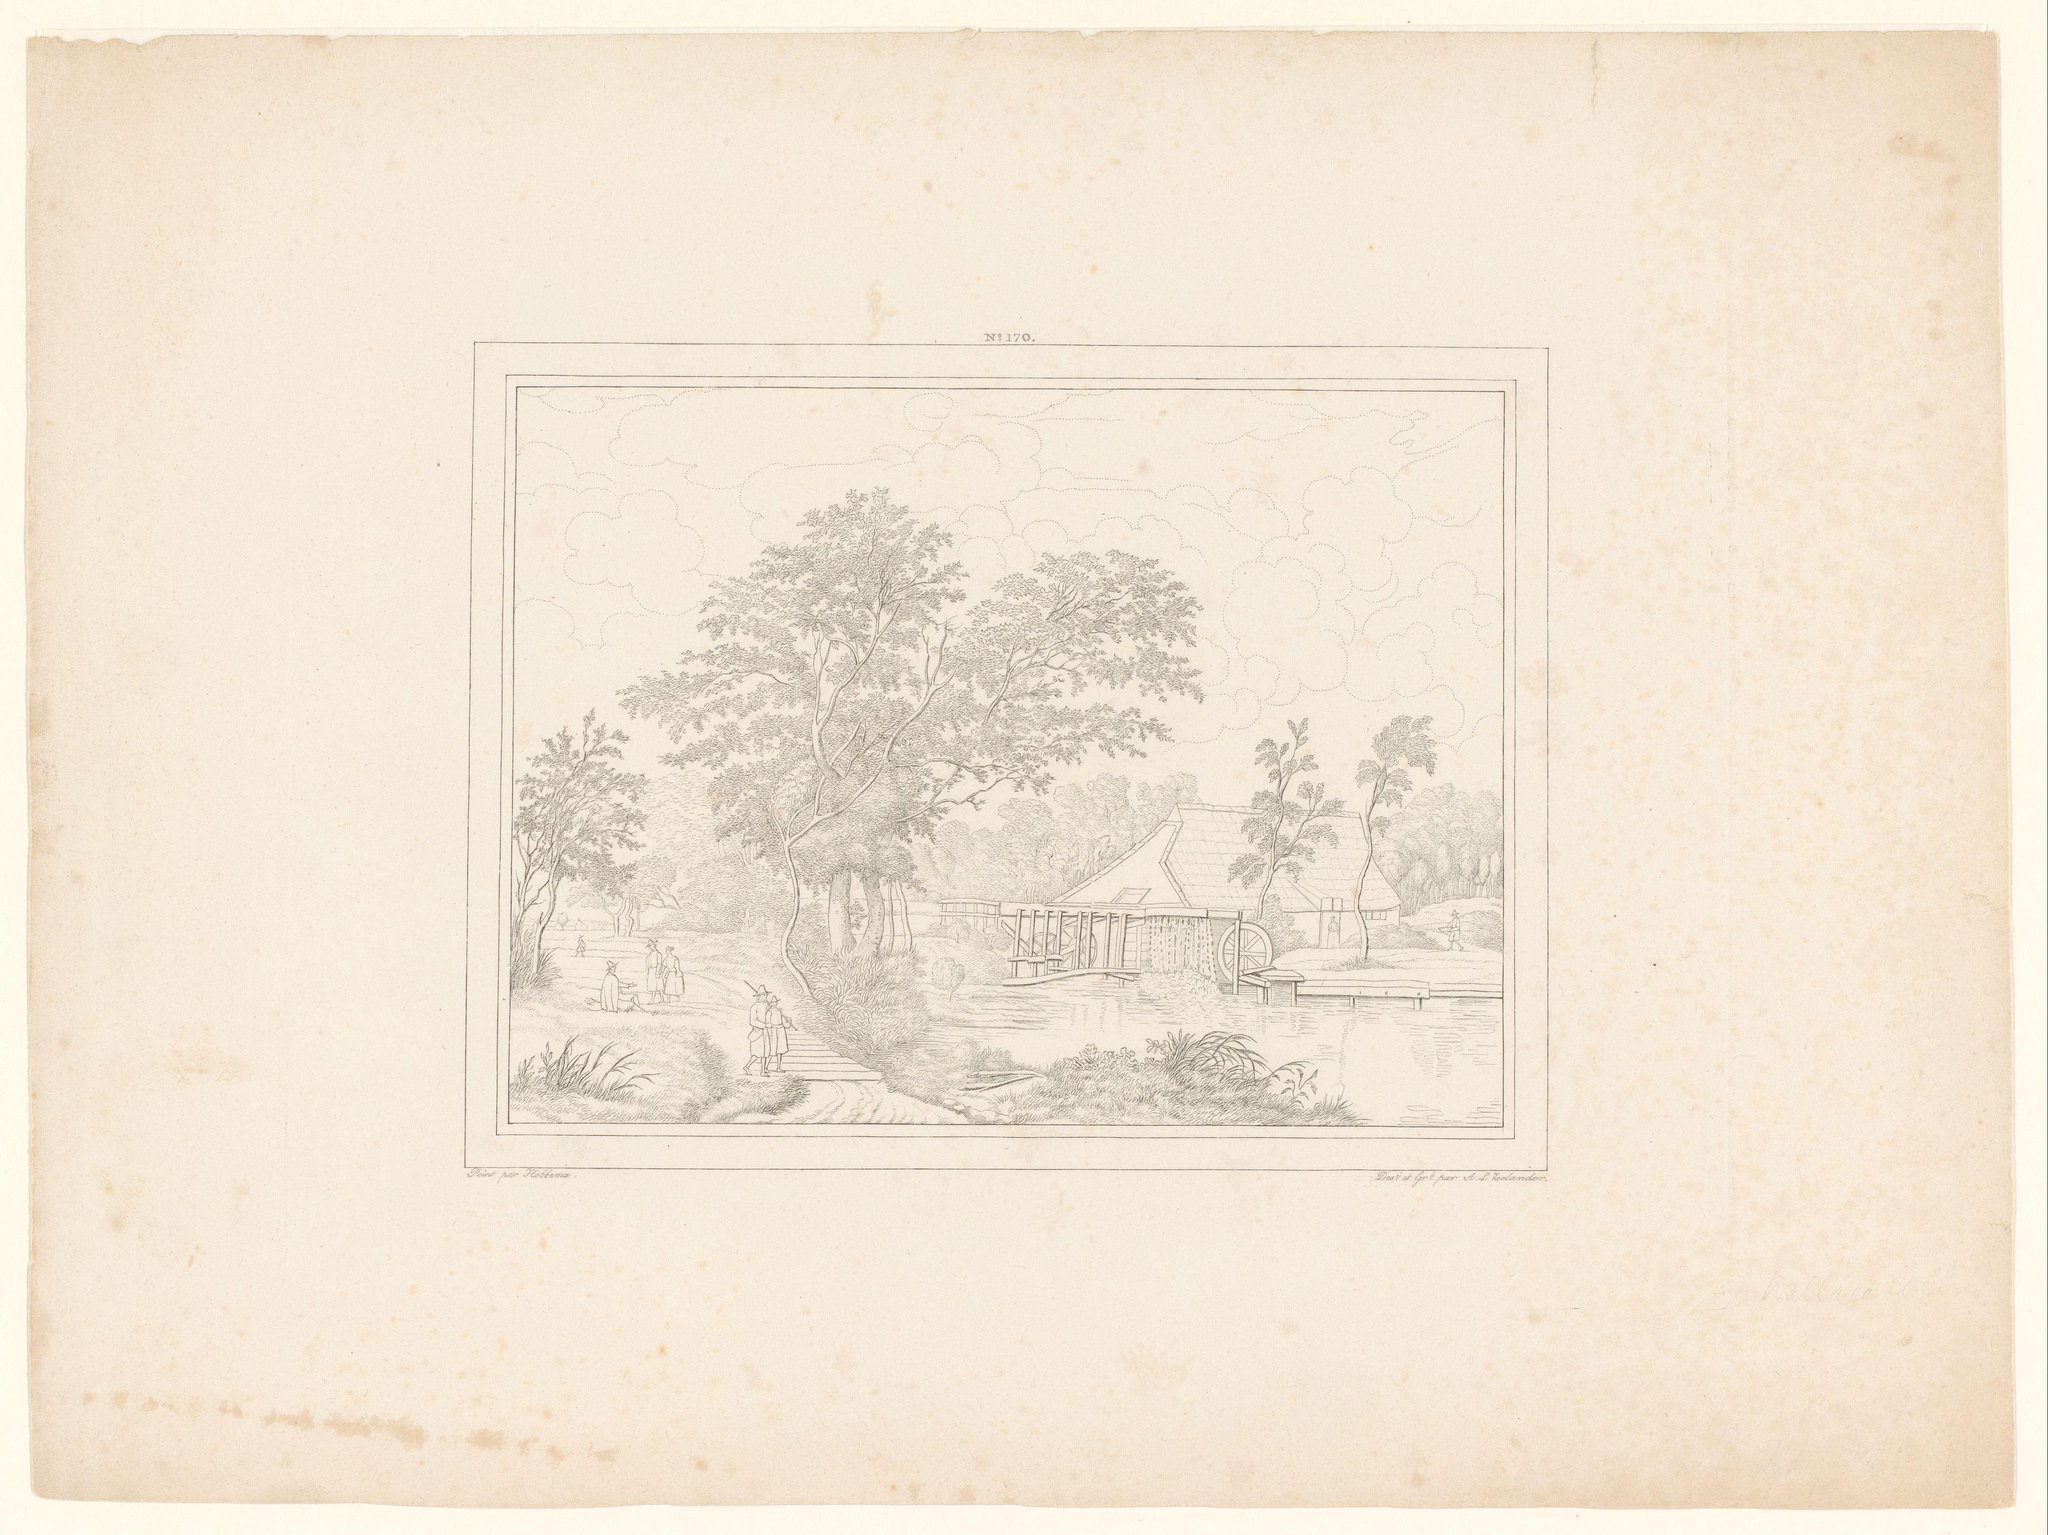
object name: print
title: Gravures au traits, dʹaprès les tableaux de la Galerie de S.M. le Roi des Pays-Bas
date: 1843-1849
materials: paper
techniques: etching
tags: watermill in landscape (+ city(-scape) with figures, staffage)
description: Prent uit: Gravures au traits, dʹaprès les tableaux de la Galerie de S.M. le Roi des Pays-Bas. Den Haag: 1849-1850.